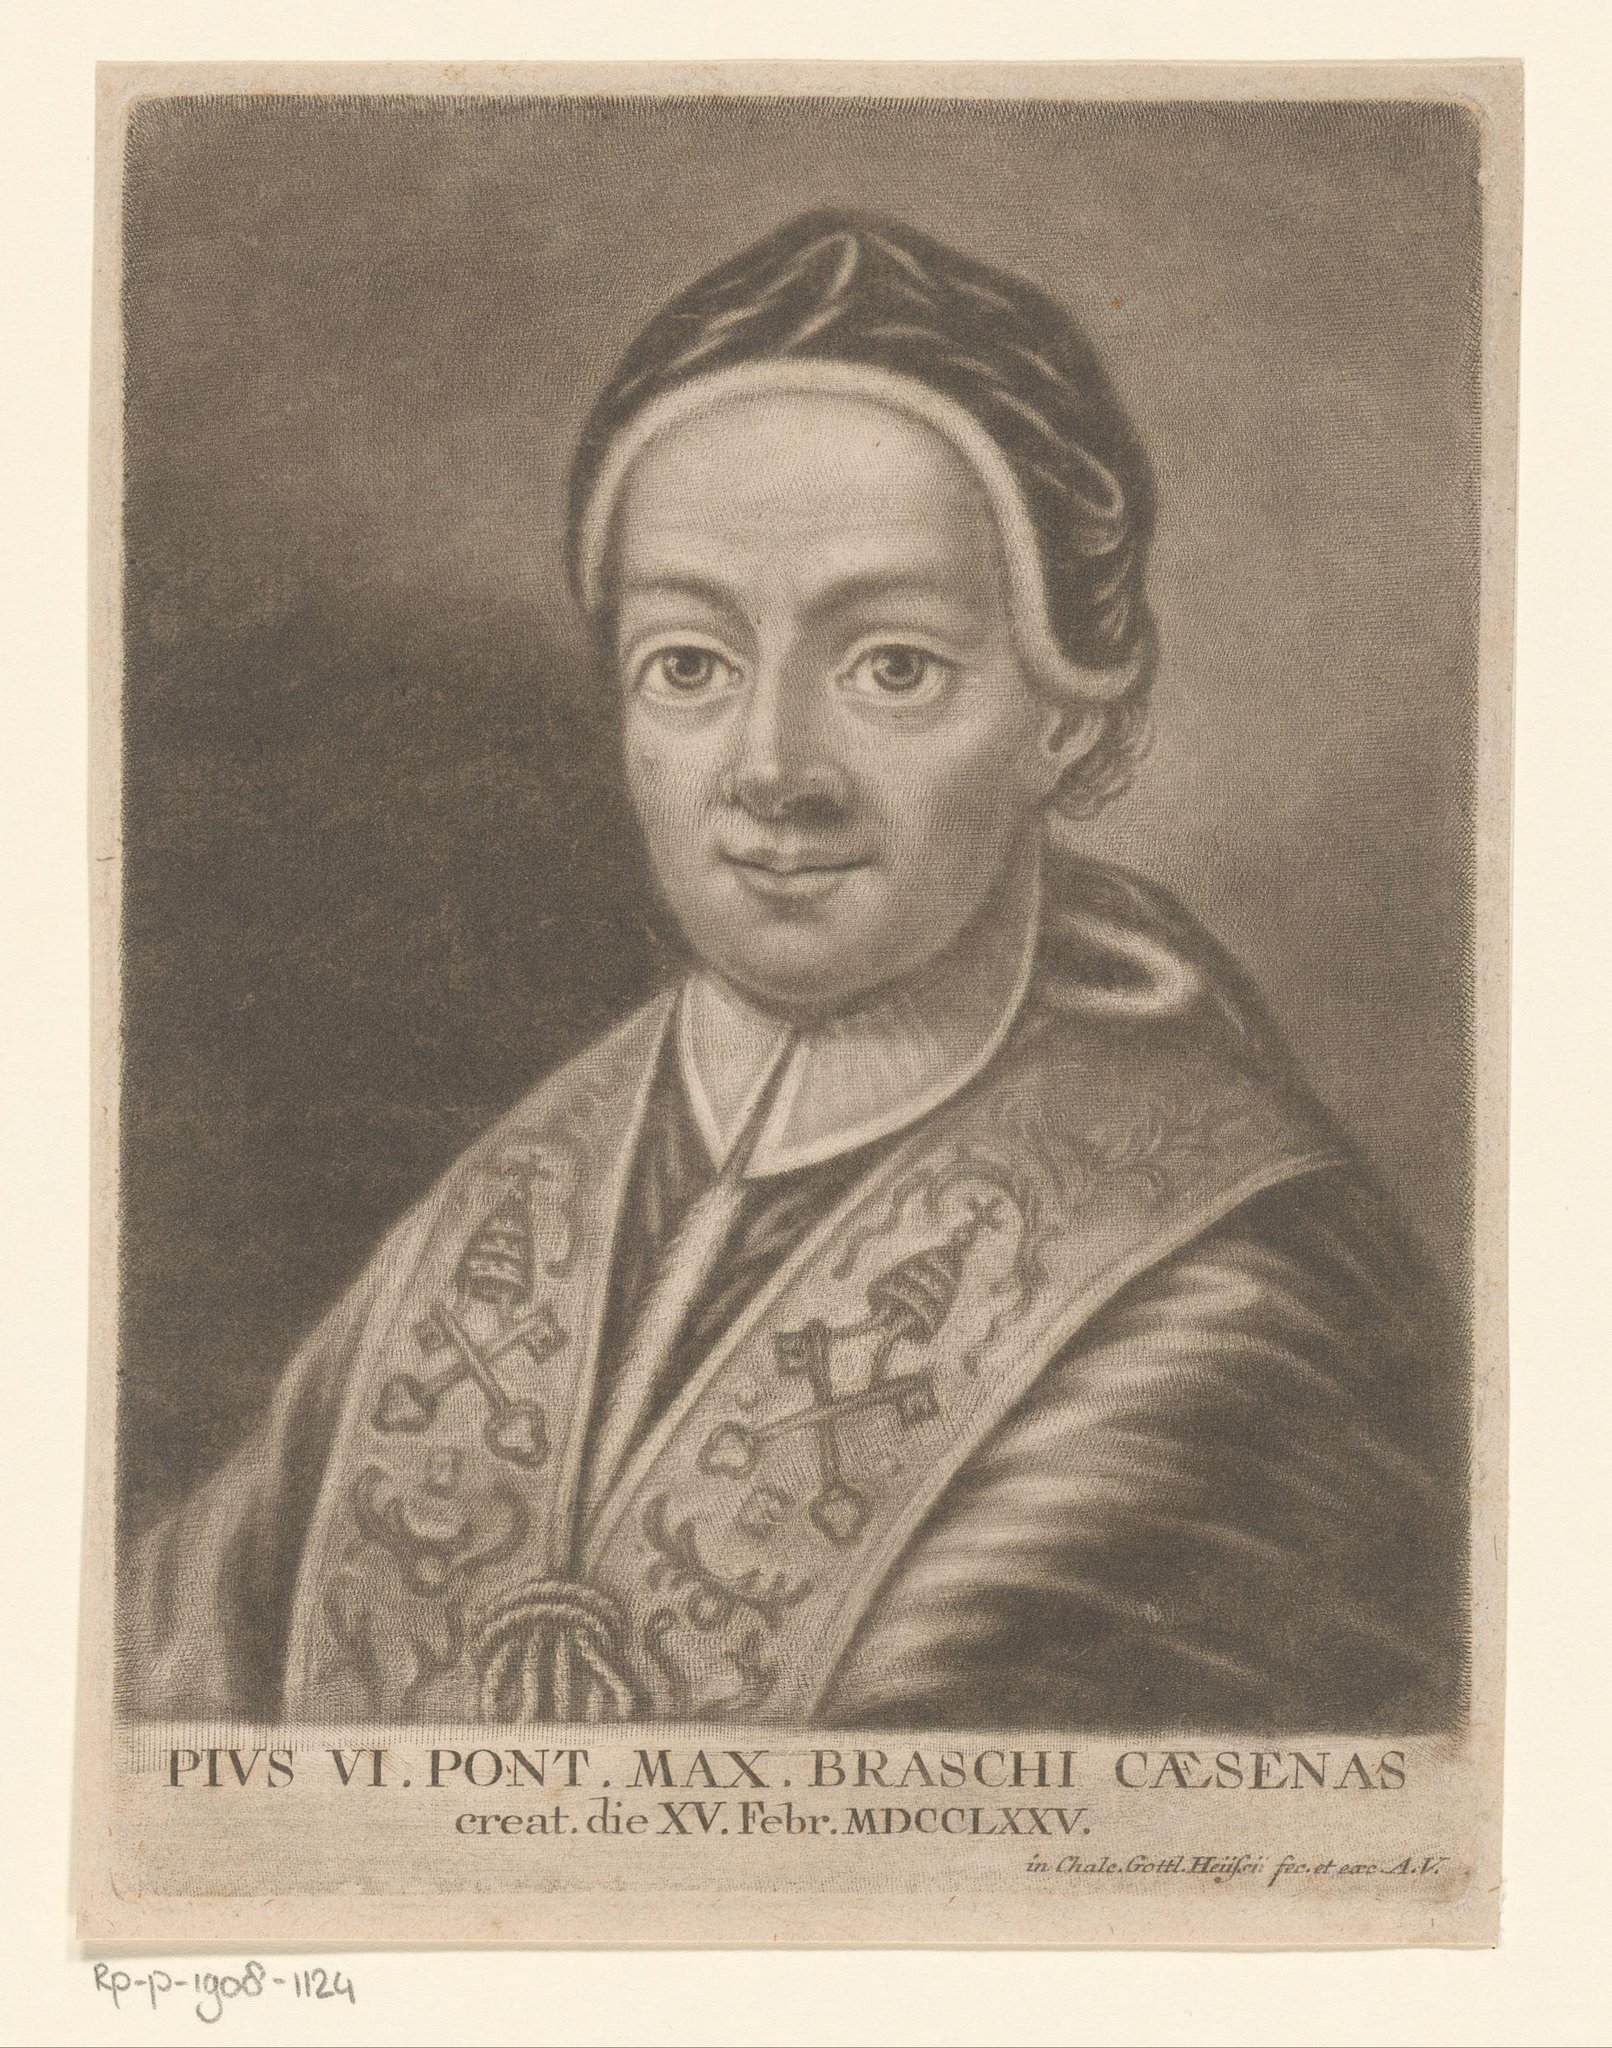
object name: print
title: Portret van paus Pius VI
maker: gottlieb heiss (ii)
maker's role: print maker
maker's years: 1723-1775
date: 1775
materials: paper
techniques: mezzotint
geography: augsburg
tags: pius vi, historical persons, pope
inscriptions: collector's mark: Lugt 2228